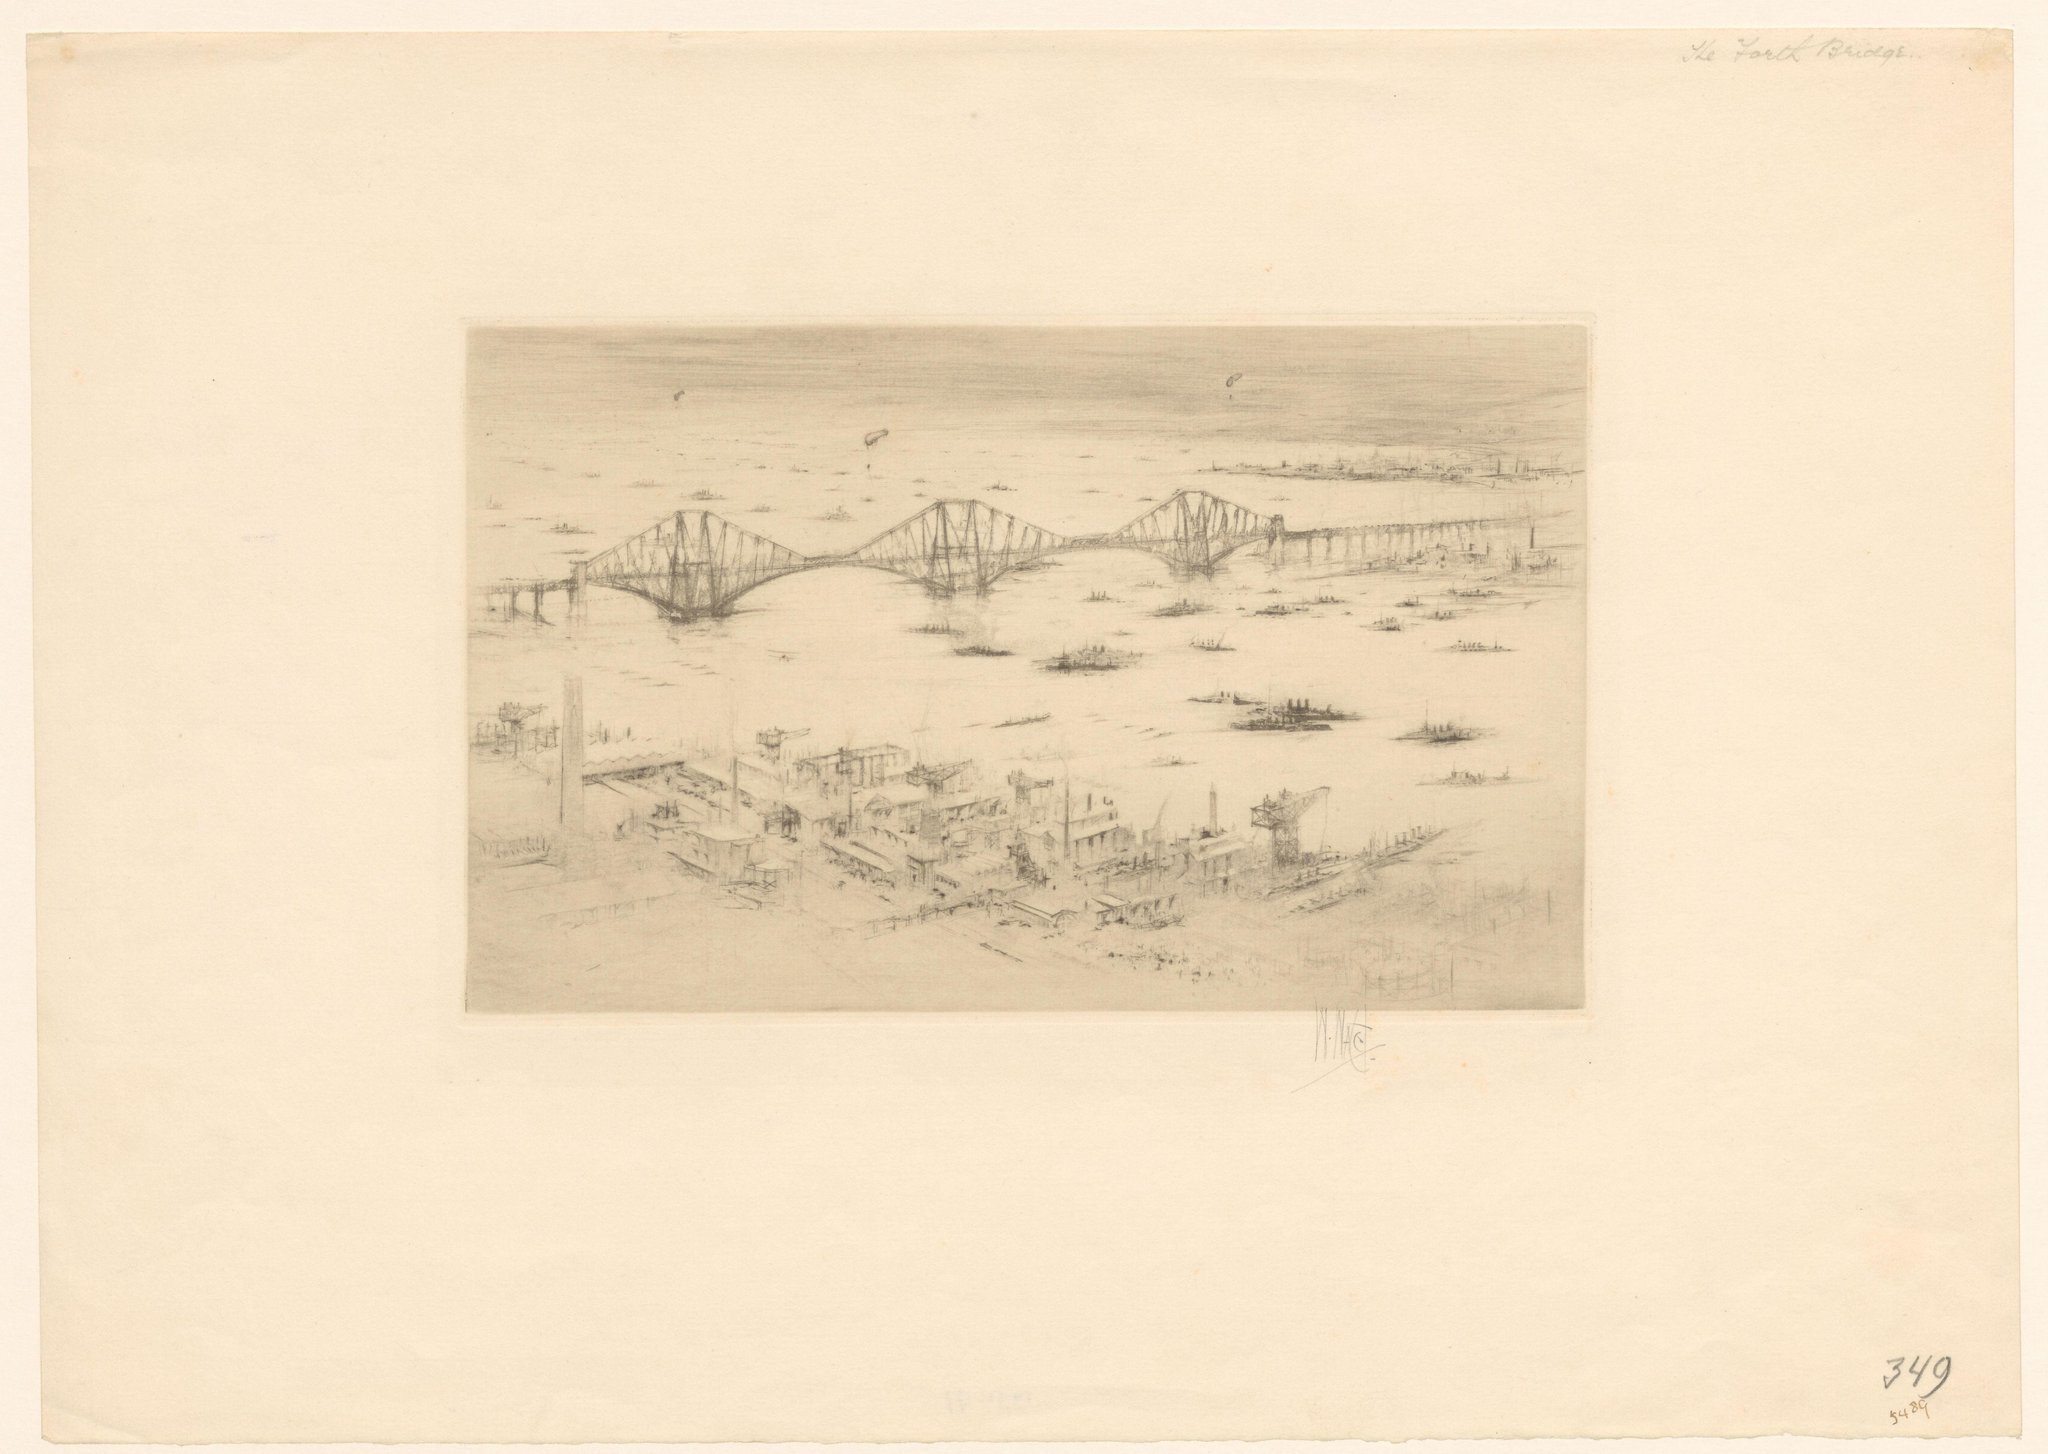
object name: print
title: Gezicht op de Forth Bridge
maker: walter hilton nash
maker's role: print maker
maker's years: 1850-1927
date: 1890-1927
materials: paper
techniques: etching, intaglio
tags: cantilever bridge, river, factory in landscape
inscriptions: signature: ‘W. Nash’, inscription: ‘34.’